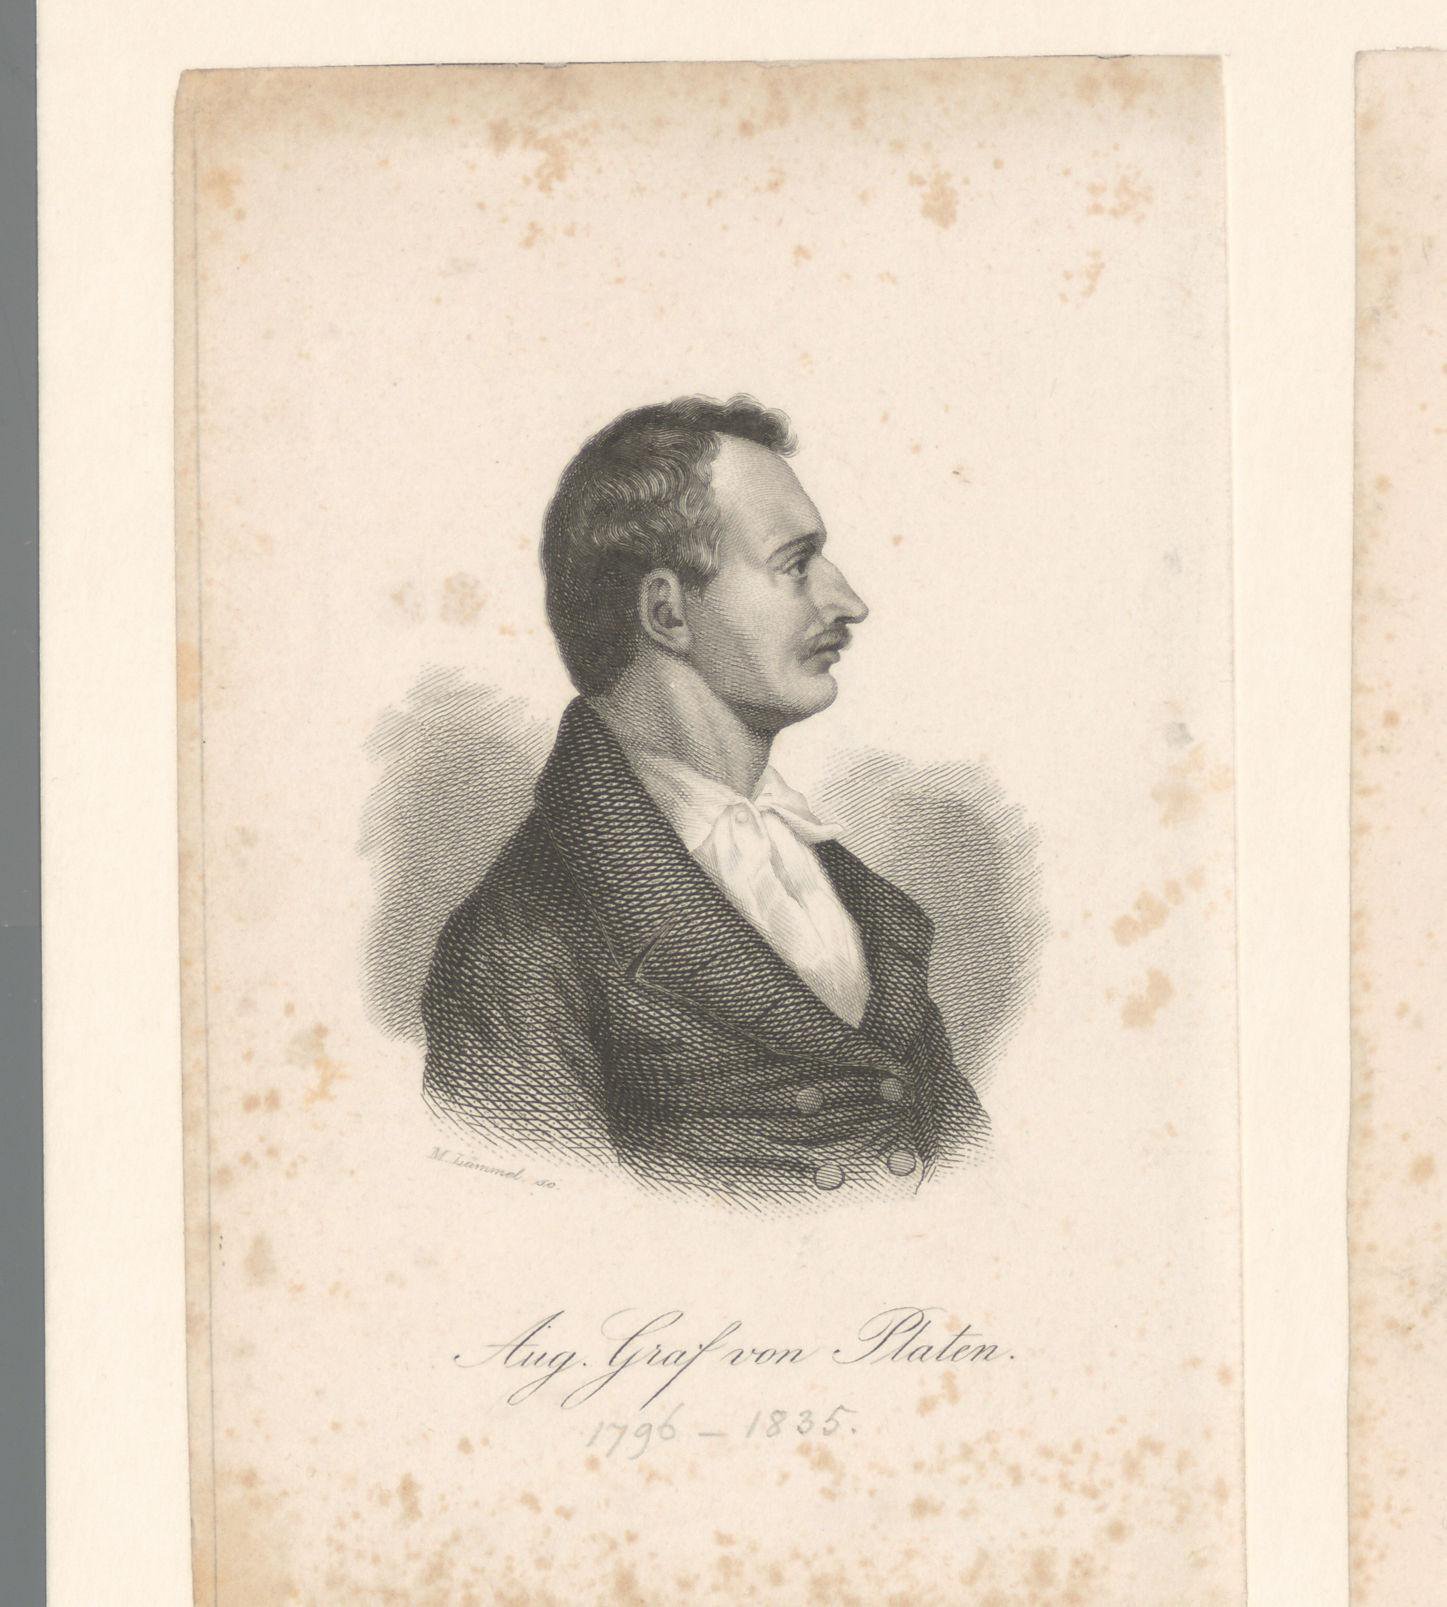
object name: print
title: Portret van August Graf von Platen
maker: moritz lämmel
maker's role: print maker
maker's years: 1822-1866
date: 1832-1866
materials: paper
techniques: engraving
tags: historical persons, portrait of a writer, officer, portrait of actor, actress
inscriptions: collector's mark: Lugt 2233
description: Een facsimile signatuur in de ondermarge.